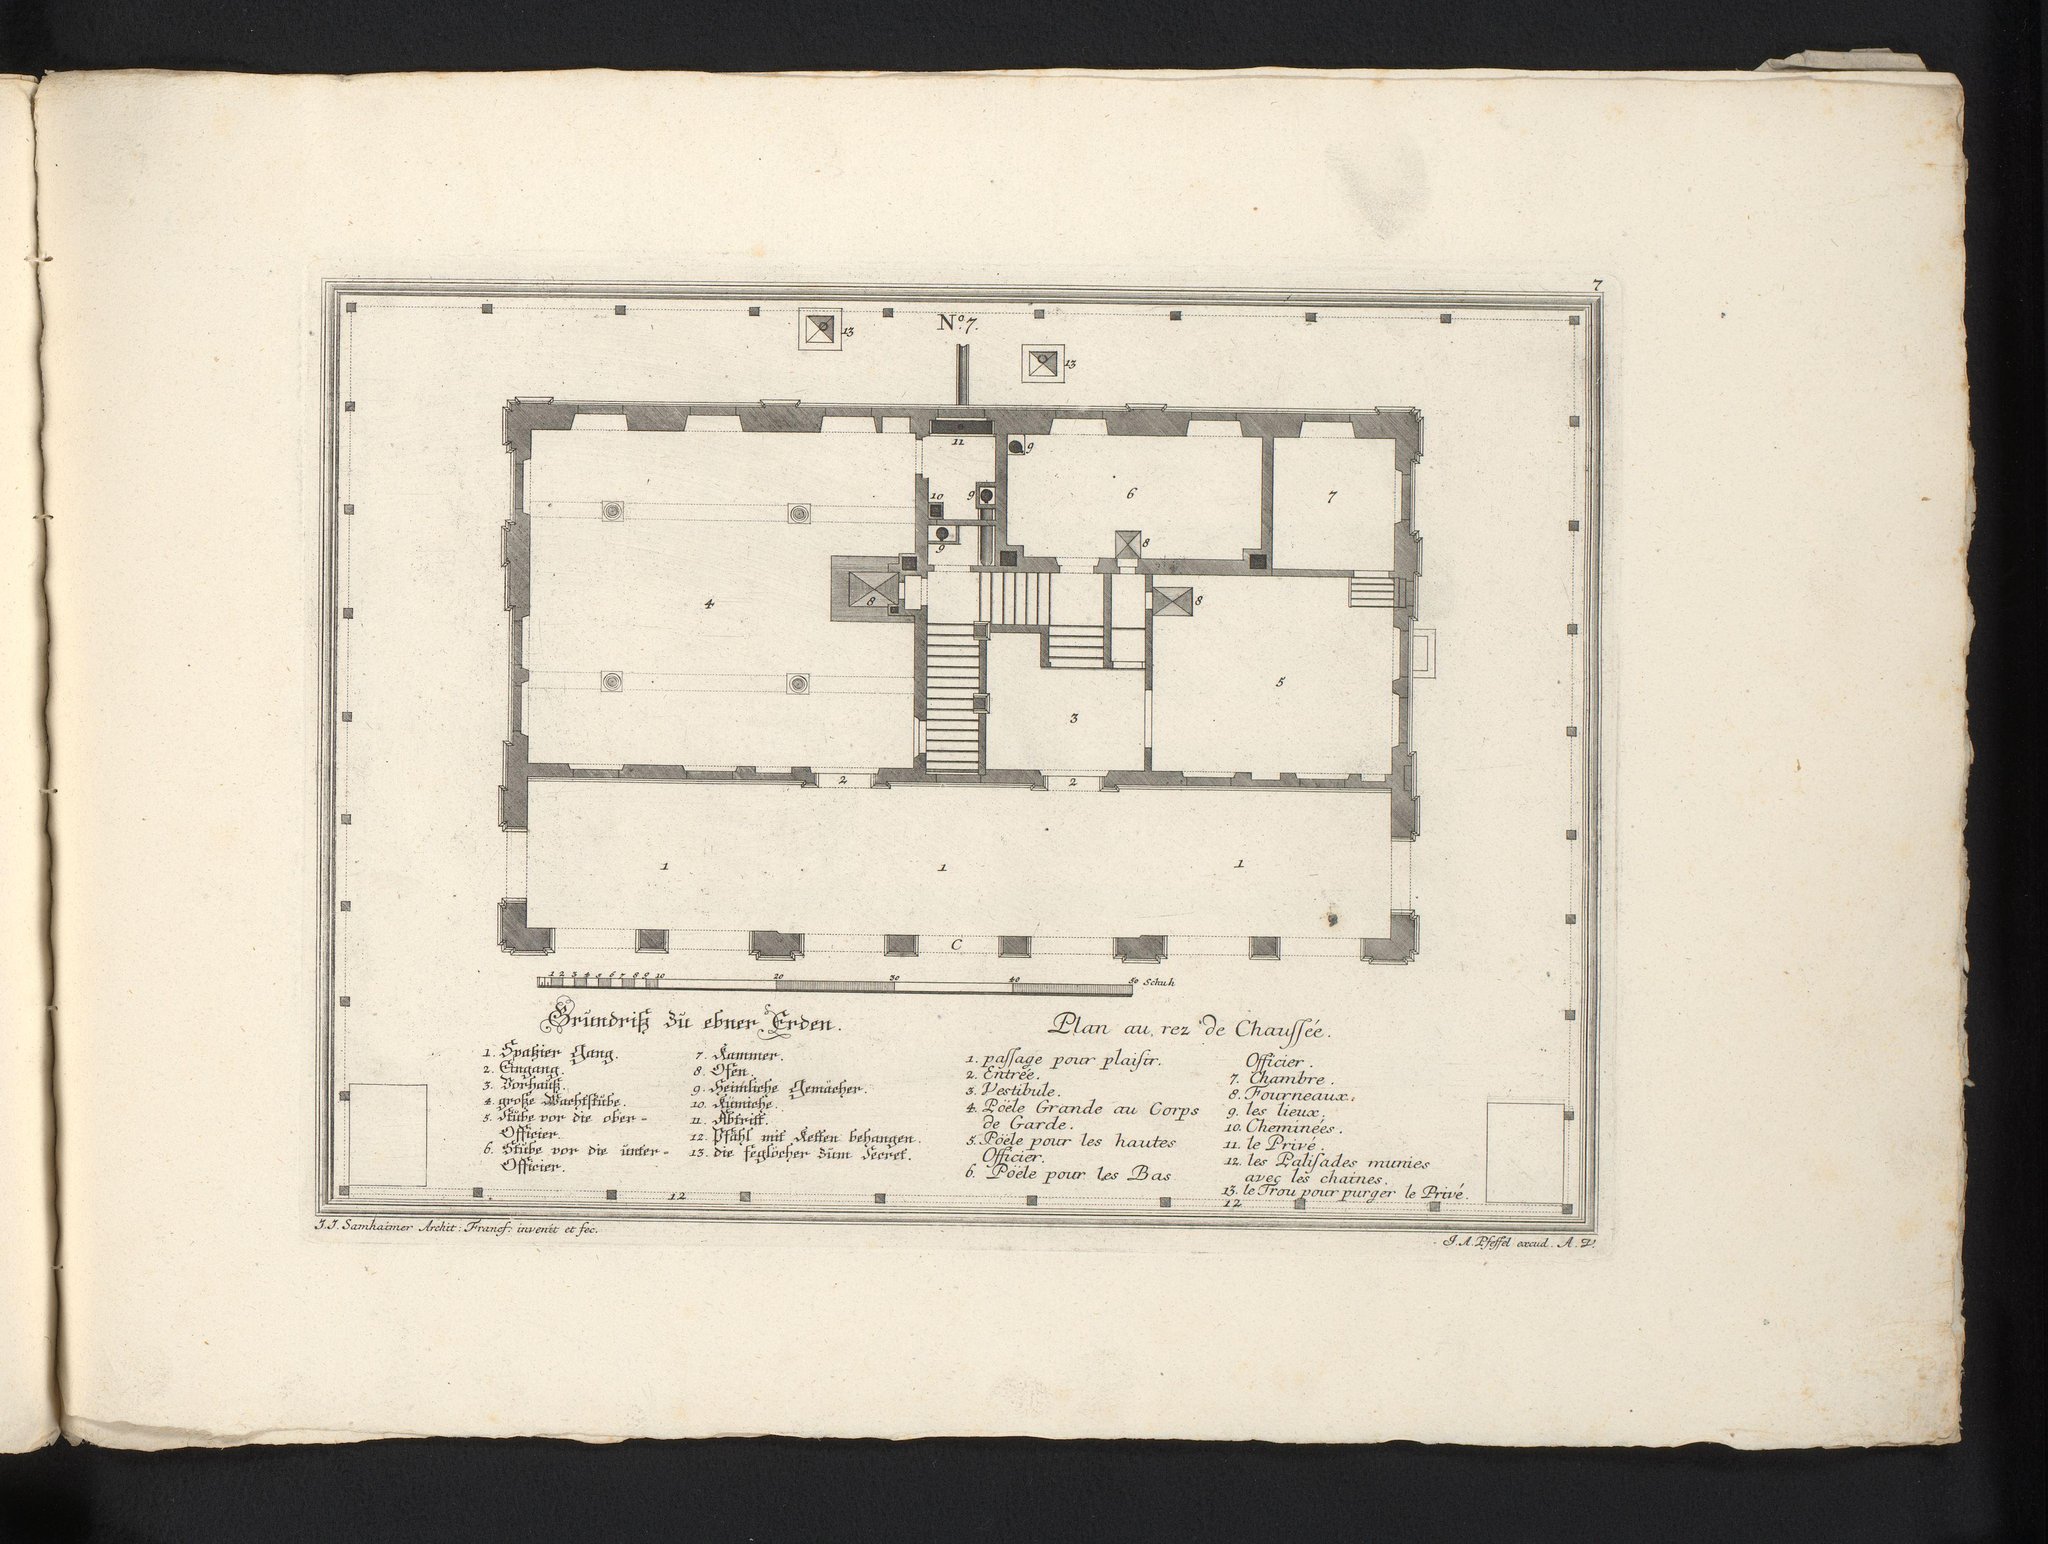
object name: print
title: Gündriss zu ebner Erden / Plan au rez de chaussée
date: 1729-1730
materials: paper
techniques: engraving, etching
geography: frankfurt am main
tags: prison, jail, barracks, plan ~ architecture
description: Boven, in het midden, en rechtsboven genummerd: 7.